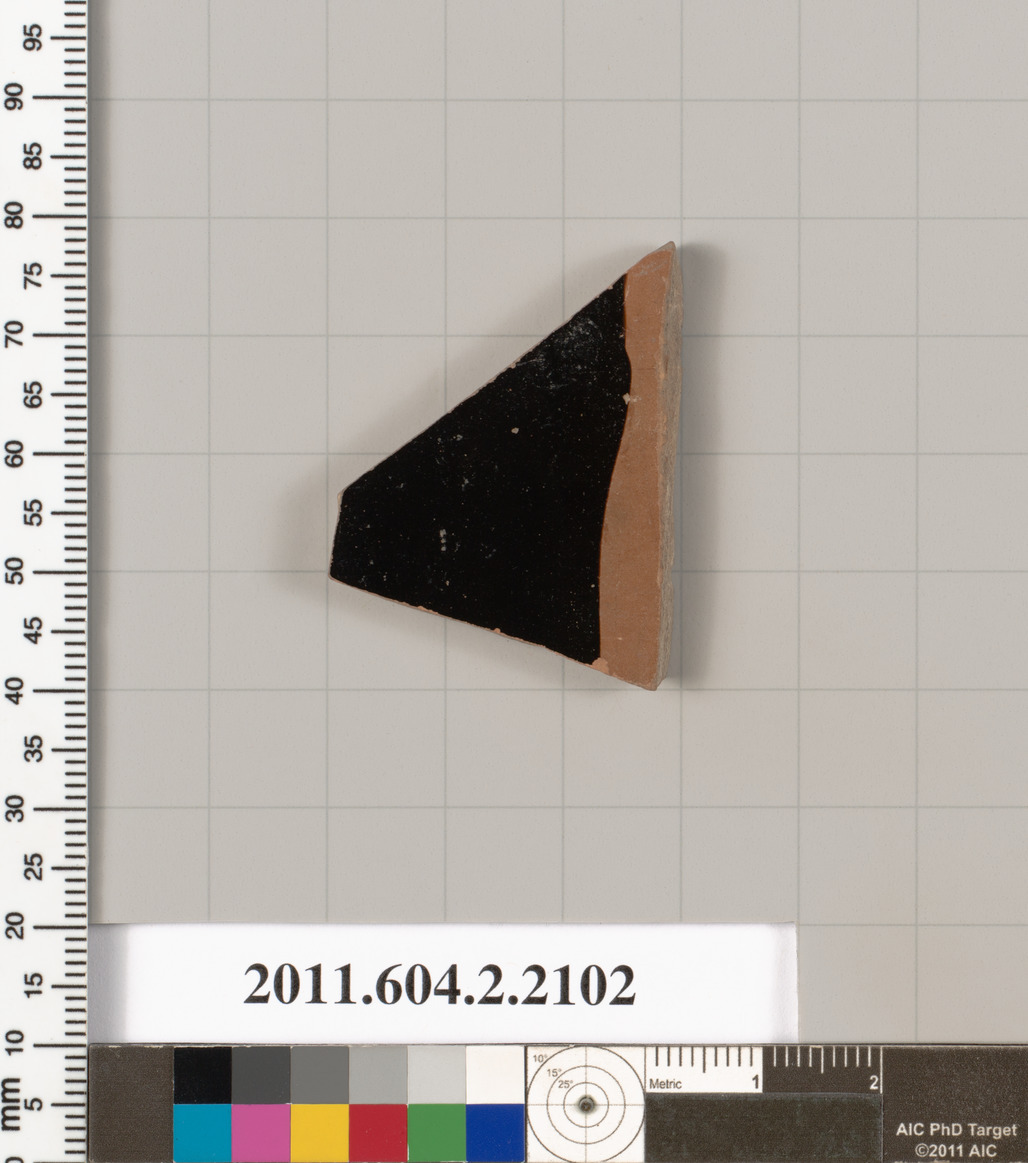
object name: pot fragment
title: Terracotta fragment of a pot; glazed on the inside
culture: greek, attic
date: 475-451 BCE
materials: terracotta